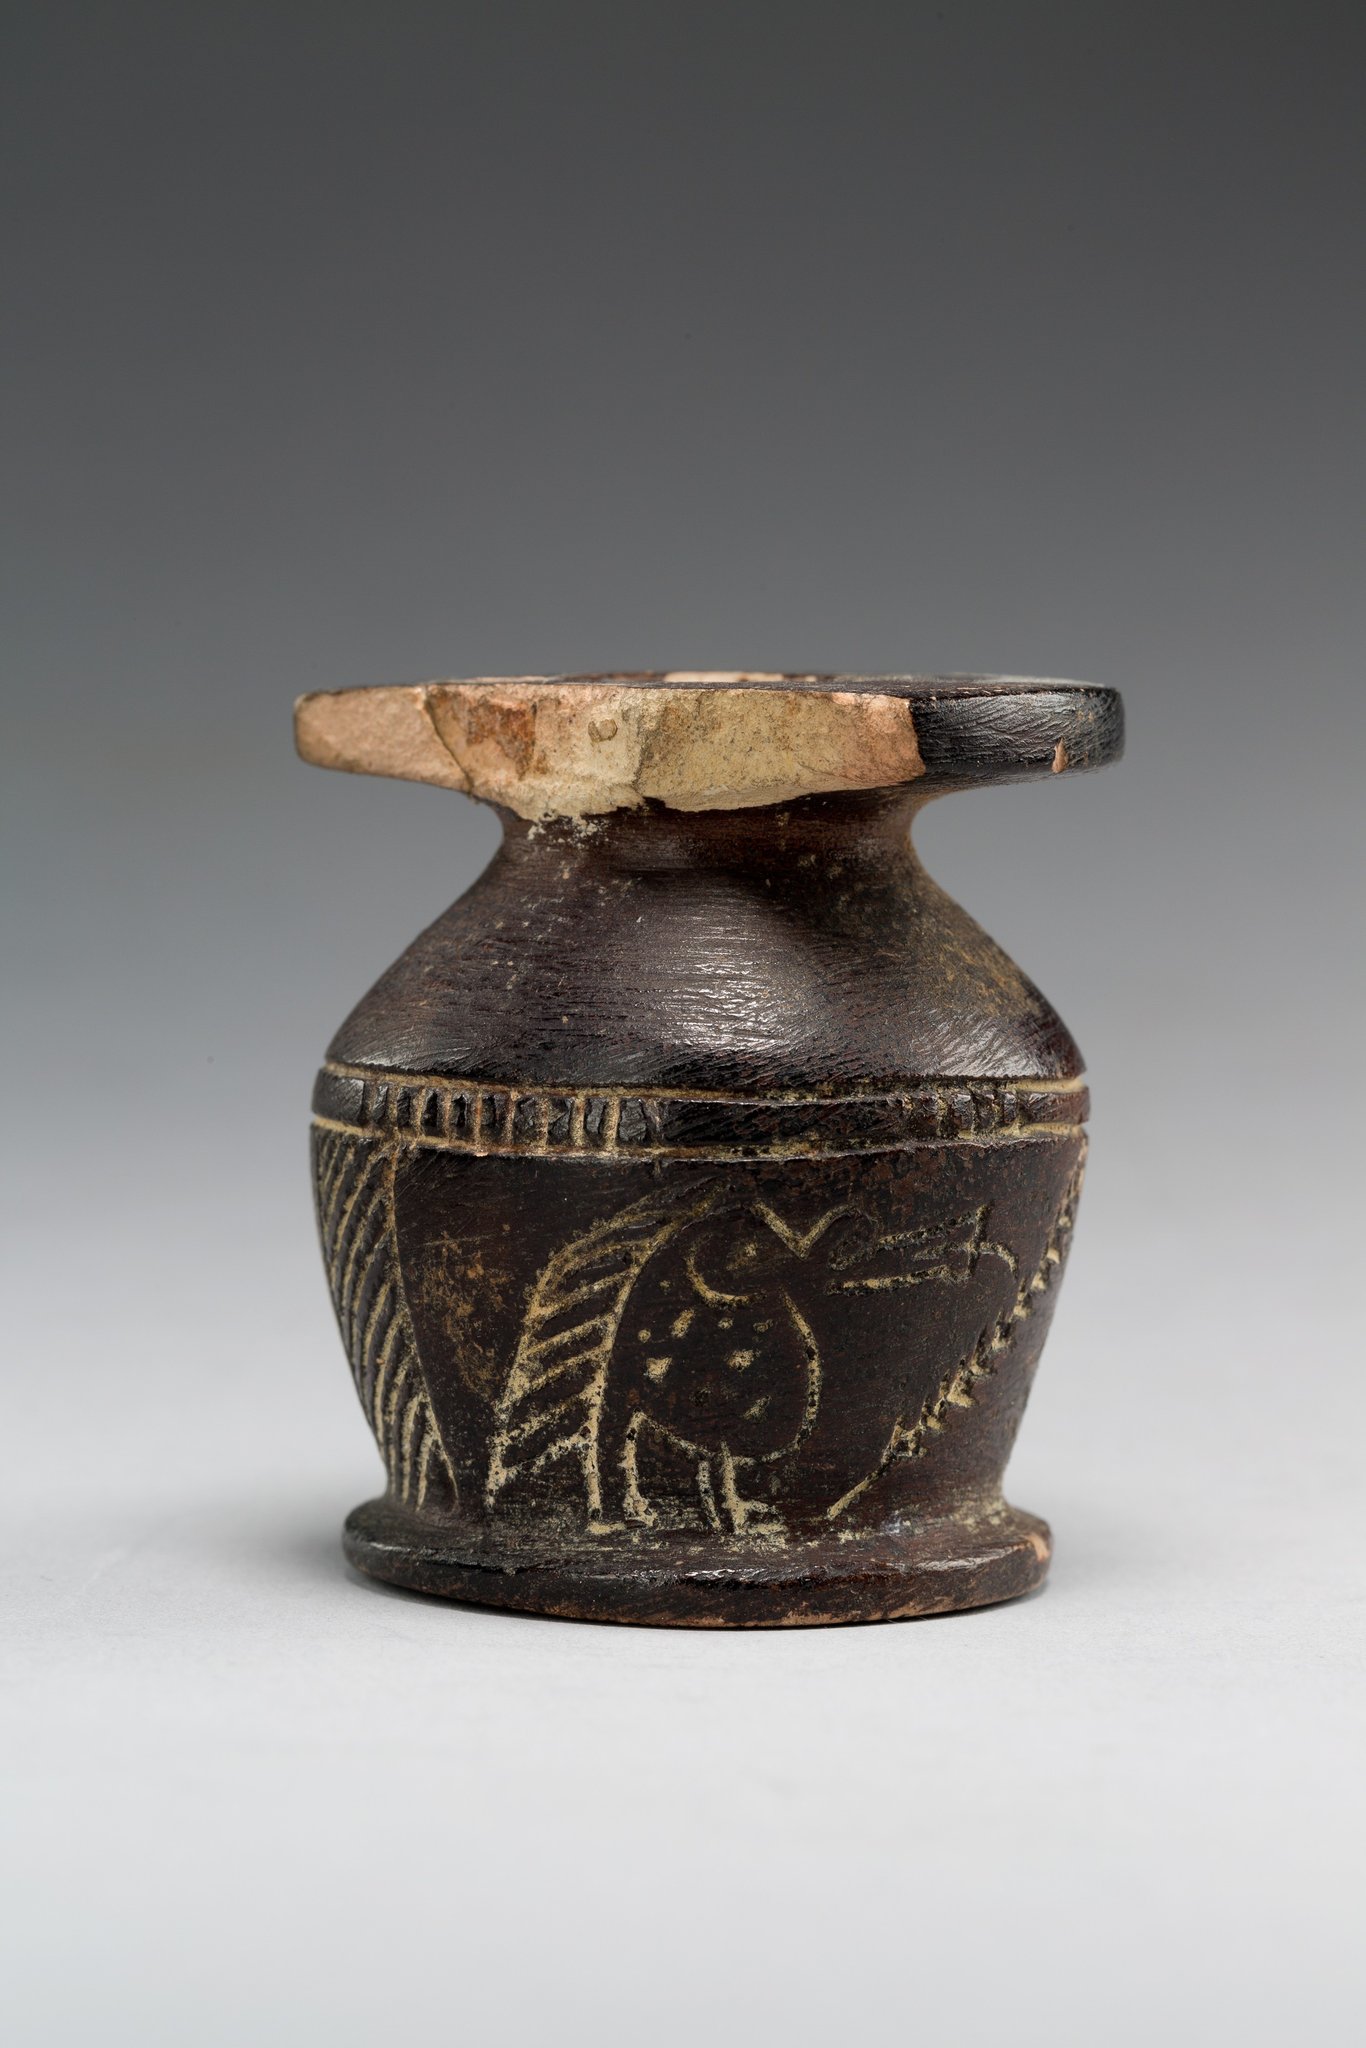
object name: kohl jar, horus falcon and grotesque figure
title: Kohl jar decorated wtih Horus falcon and grotesque figure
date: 1550-1295 BCE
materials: limestone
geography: egypt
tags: falcons